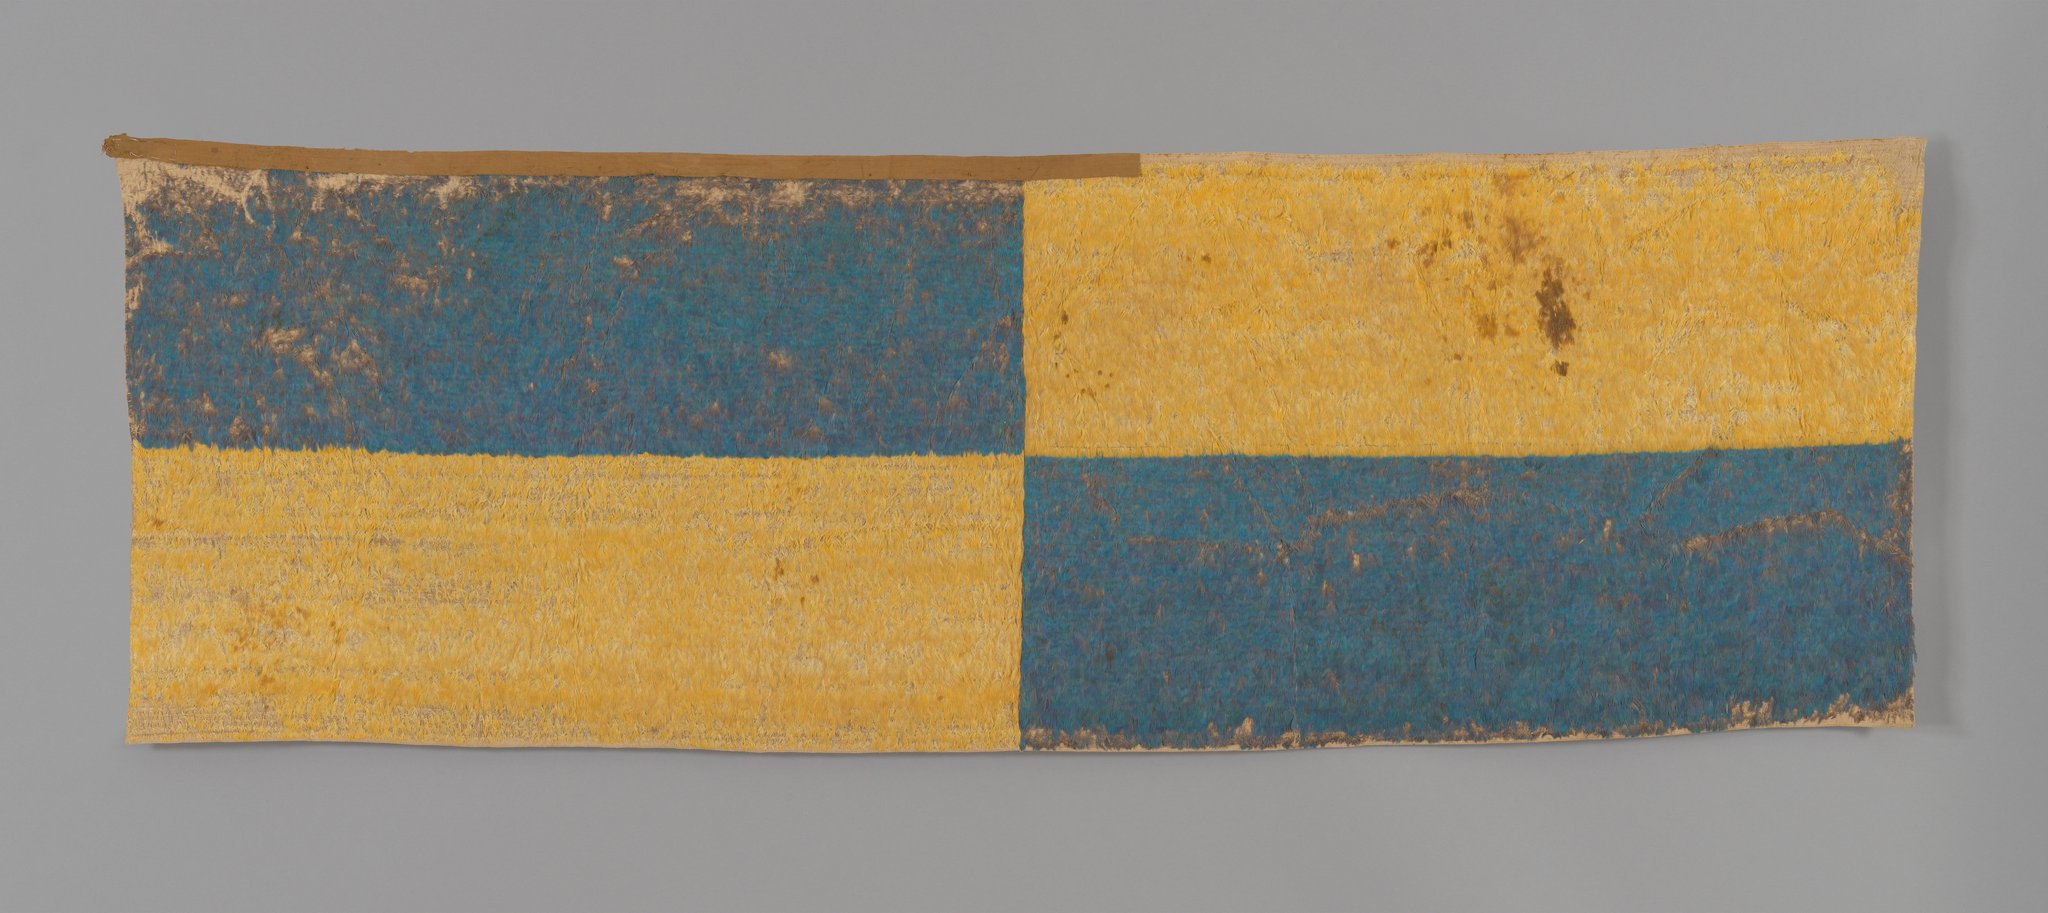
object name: panel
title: Feathered Panel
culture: wari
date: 600-900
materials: animal fiber, cotton, feather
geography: peru